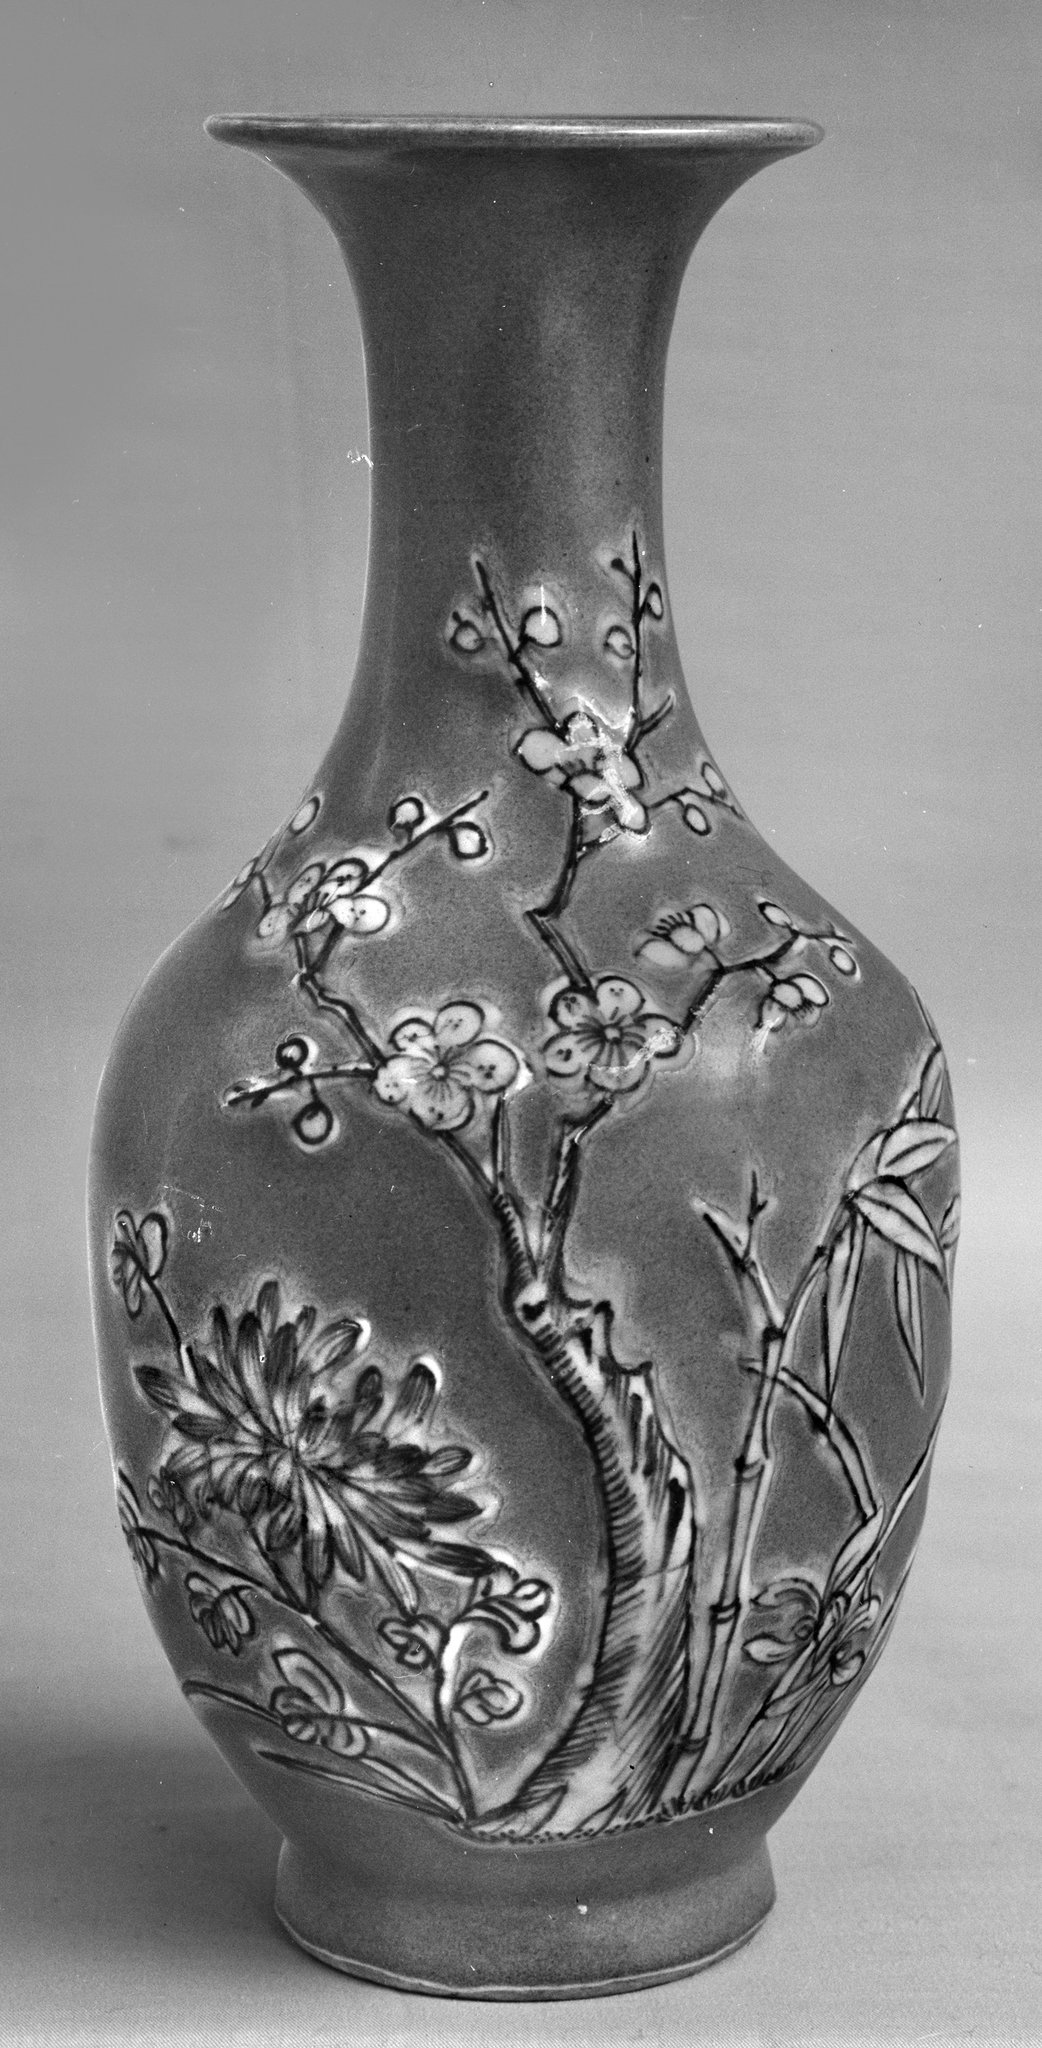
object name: vase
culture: chinese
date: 1801-1850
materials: glaze, porcelain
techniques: relief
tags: flowers,leaves